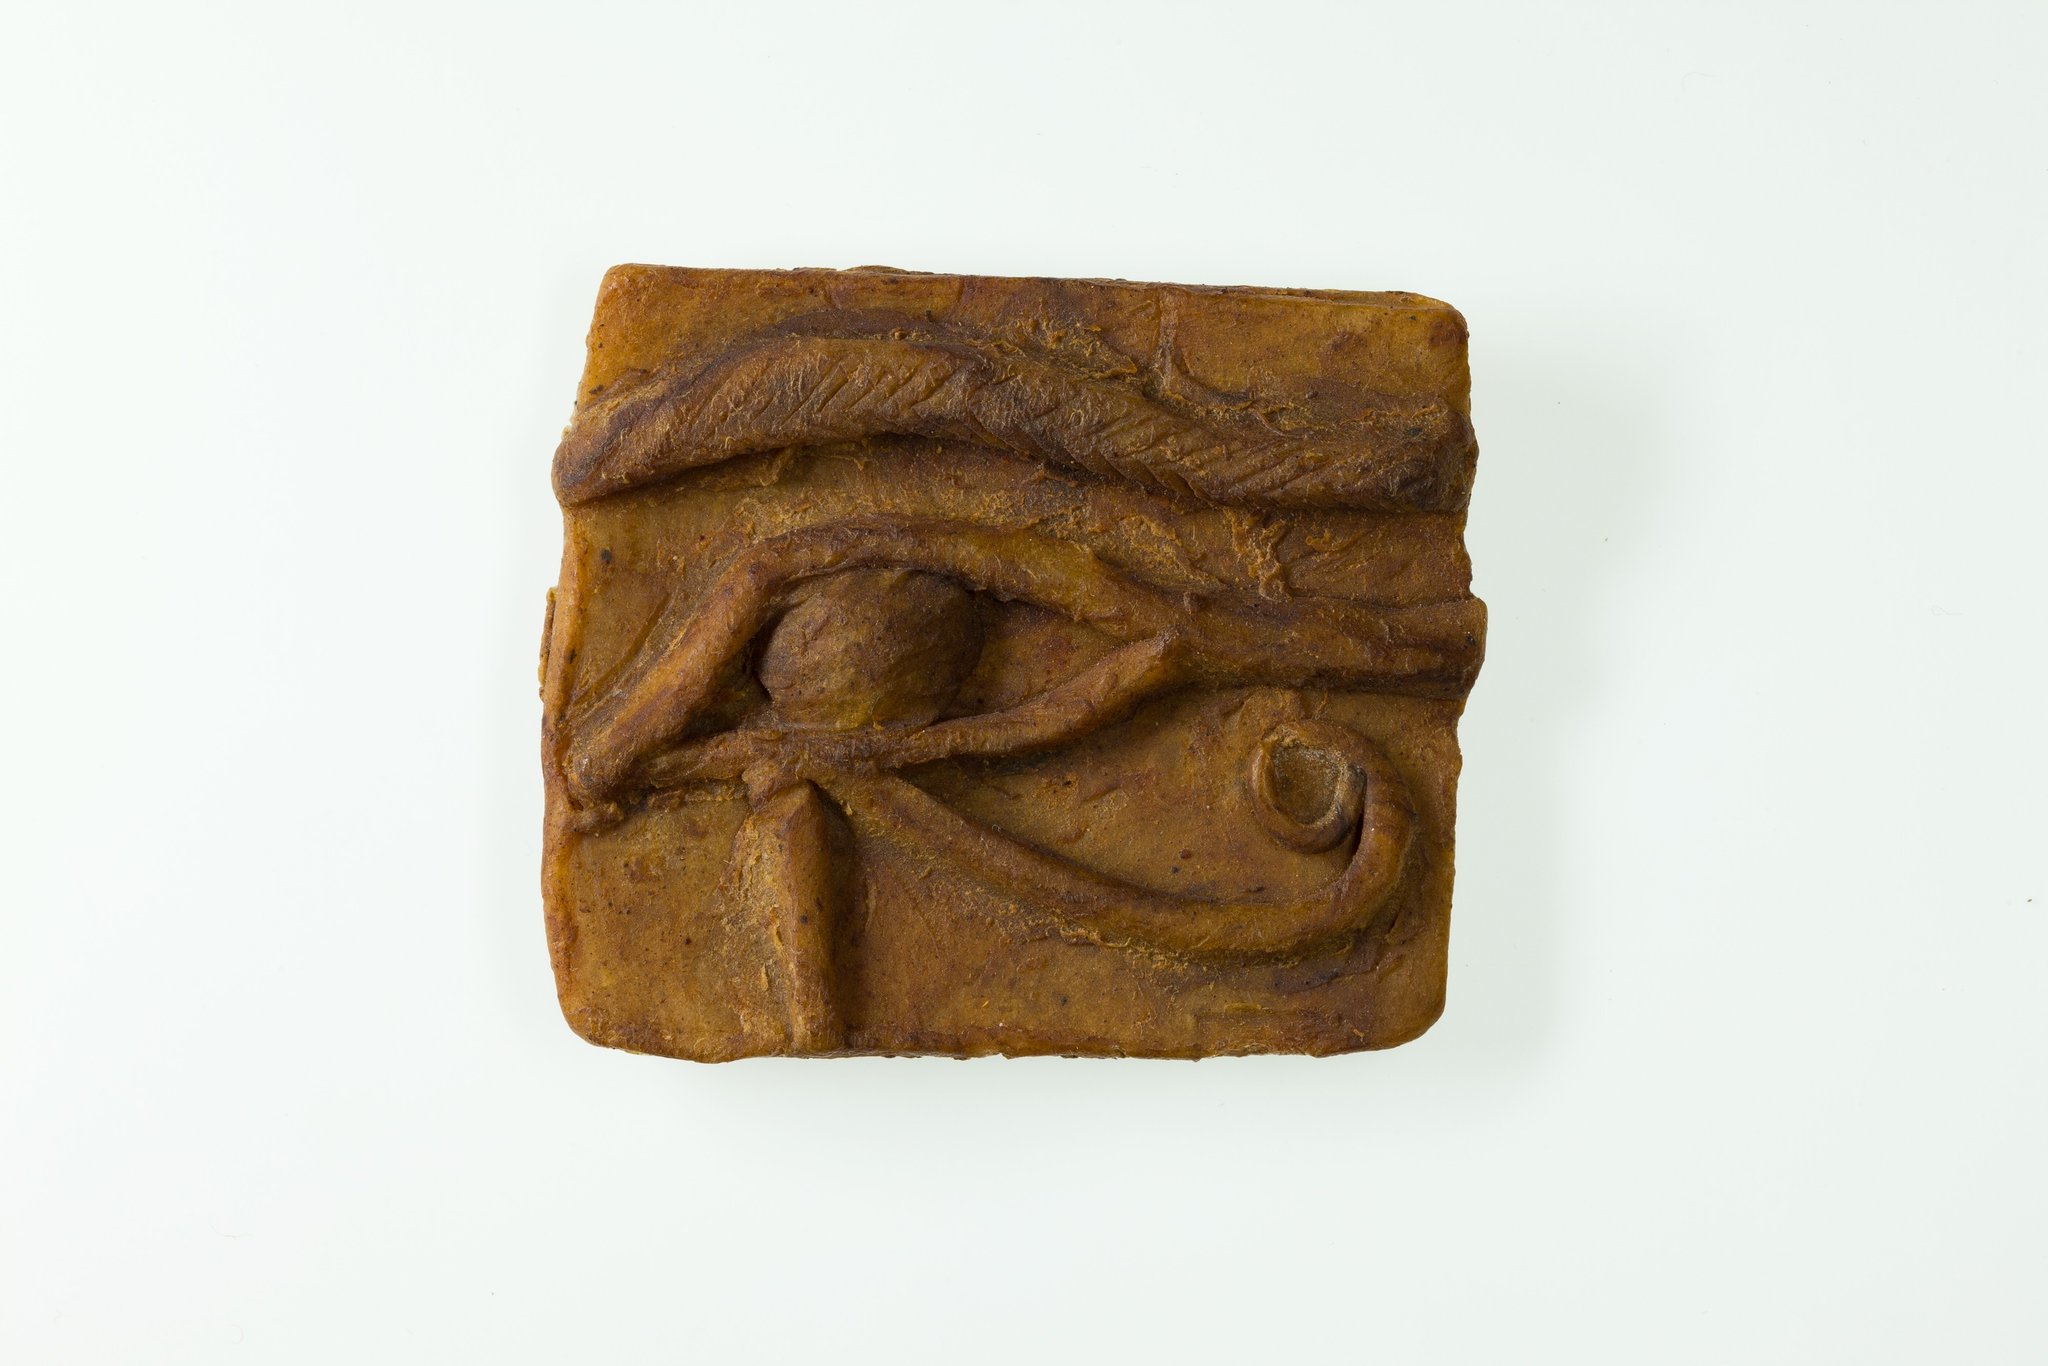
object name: amulet, wedjat eye, tiye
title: Wedjat Incision Plaque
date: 1070-945 BCE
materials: wax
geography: egypt